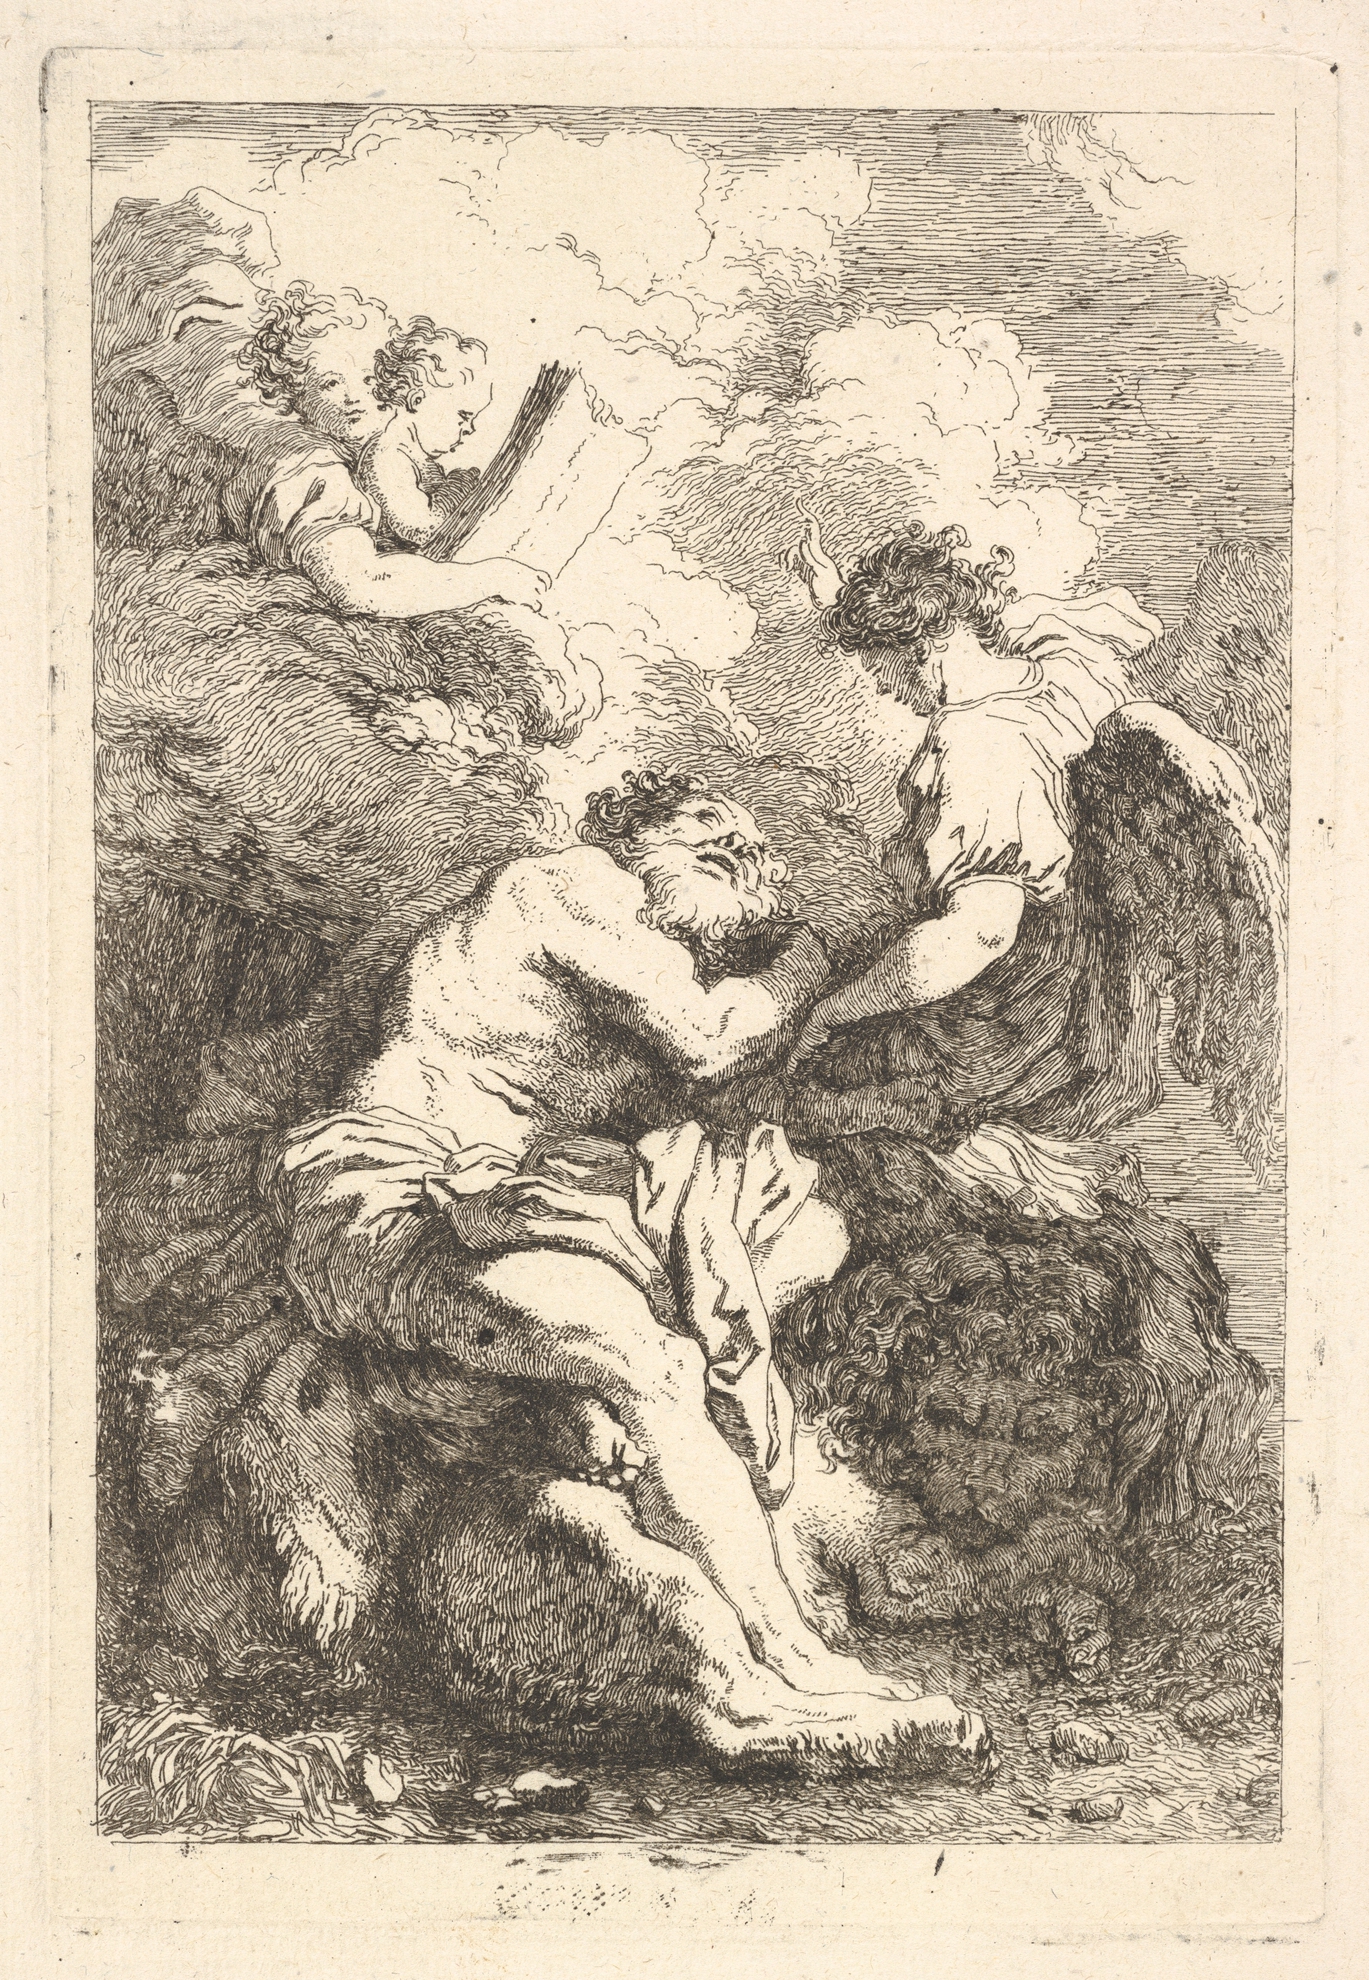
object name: print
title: The Vision of Saint Jerome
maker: jean honoré fragonard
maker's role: artist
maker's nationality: french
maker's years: 1732-1806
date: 1761-1765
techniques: etching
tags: children,lions,angels,saint jerome